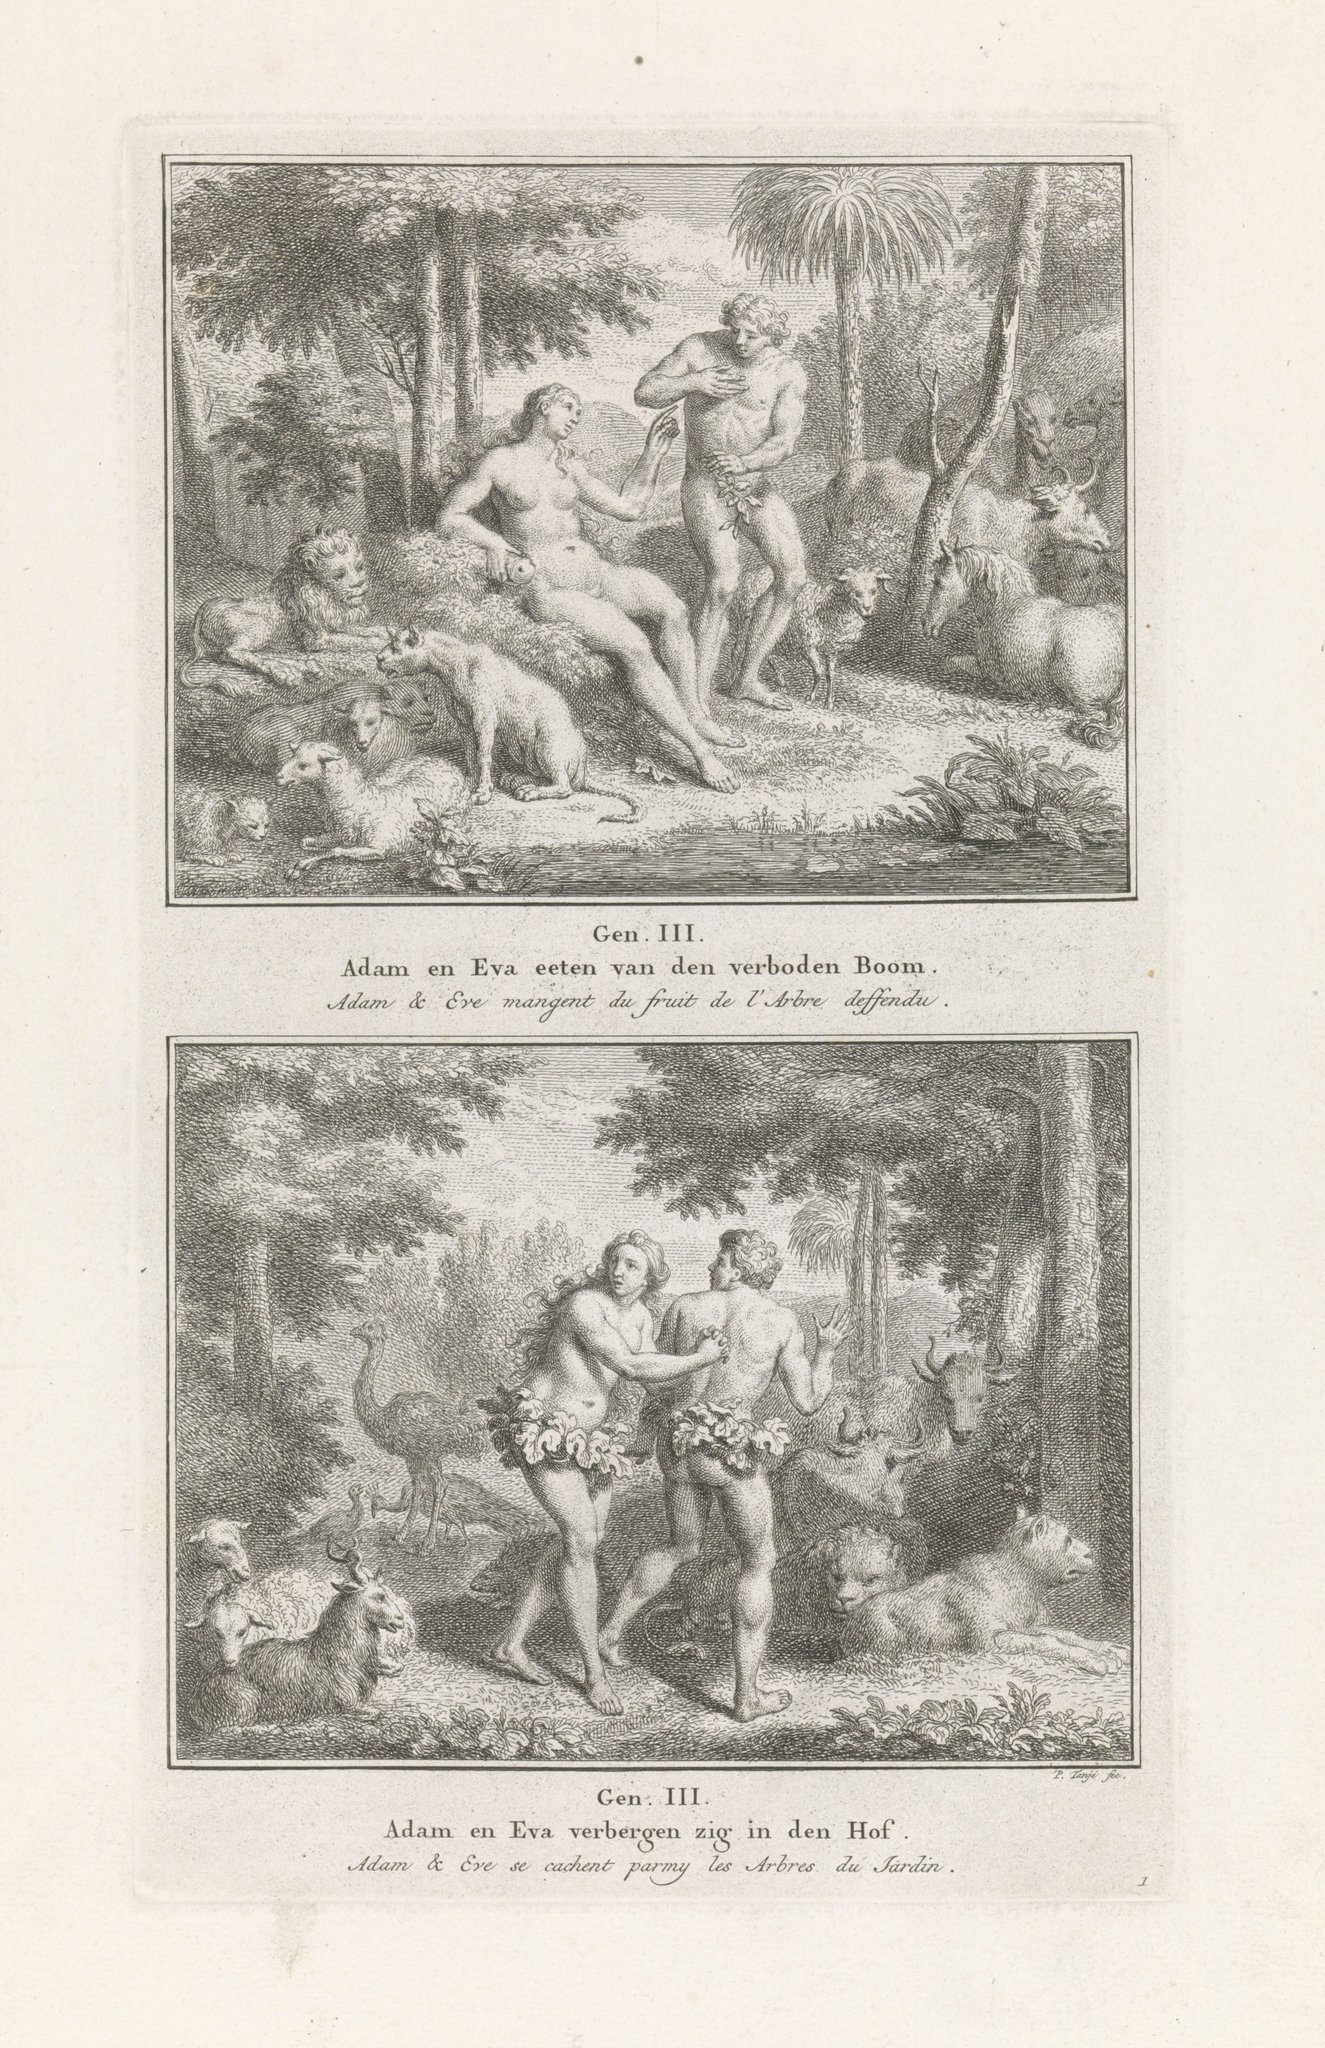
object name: book illustration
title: Adam en Eva eten van de vrucht / Adam en Eva verbergen zich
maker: pieter tanjé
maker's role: draughtsman, print maker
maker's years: 1706-1761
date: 1716-1761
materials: paper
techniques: engraving, etching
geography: amsterdam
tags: adam and eve holding (and possibly eating) the fruit, adam and eve discover their nakedness; they cover themselves with their hands or with leaves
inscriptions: collector's mark: Lugt 3937, collector's mark: Lugt 2233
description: Prent uit: Hamelsveld, Ysbrand van. De gewigtigste geschiedenissen des Bybels, afgebeeld in twee honderd twee en vĳftig printverbeeldingen (...) met eene zaaklĳke uitbreiding opgehelderd. Amsterdam: Jan de Groot, Gerrit Warnars, Petrus van Hengst, Dordrecht: Abraham Blussé, Pieter Blussé, Leiden: Samuel Luchtmans (III), Johannes Luchtmans, Harlingen: Volkert van der Plaats, 1791.